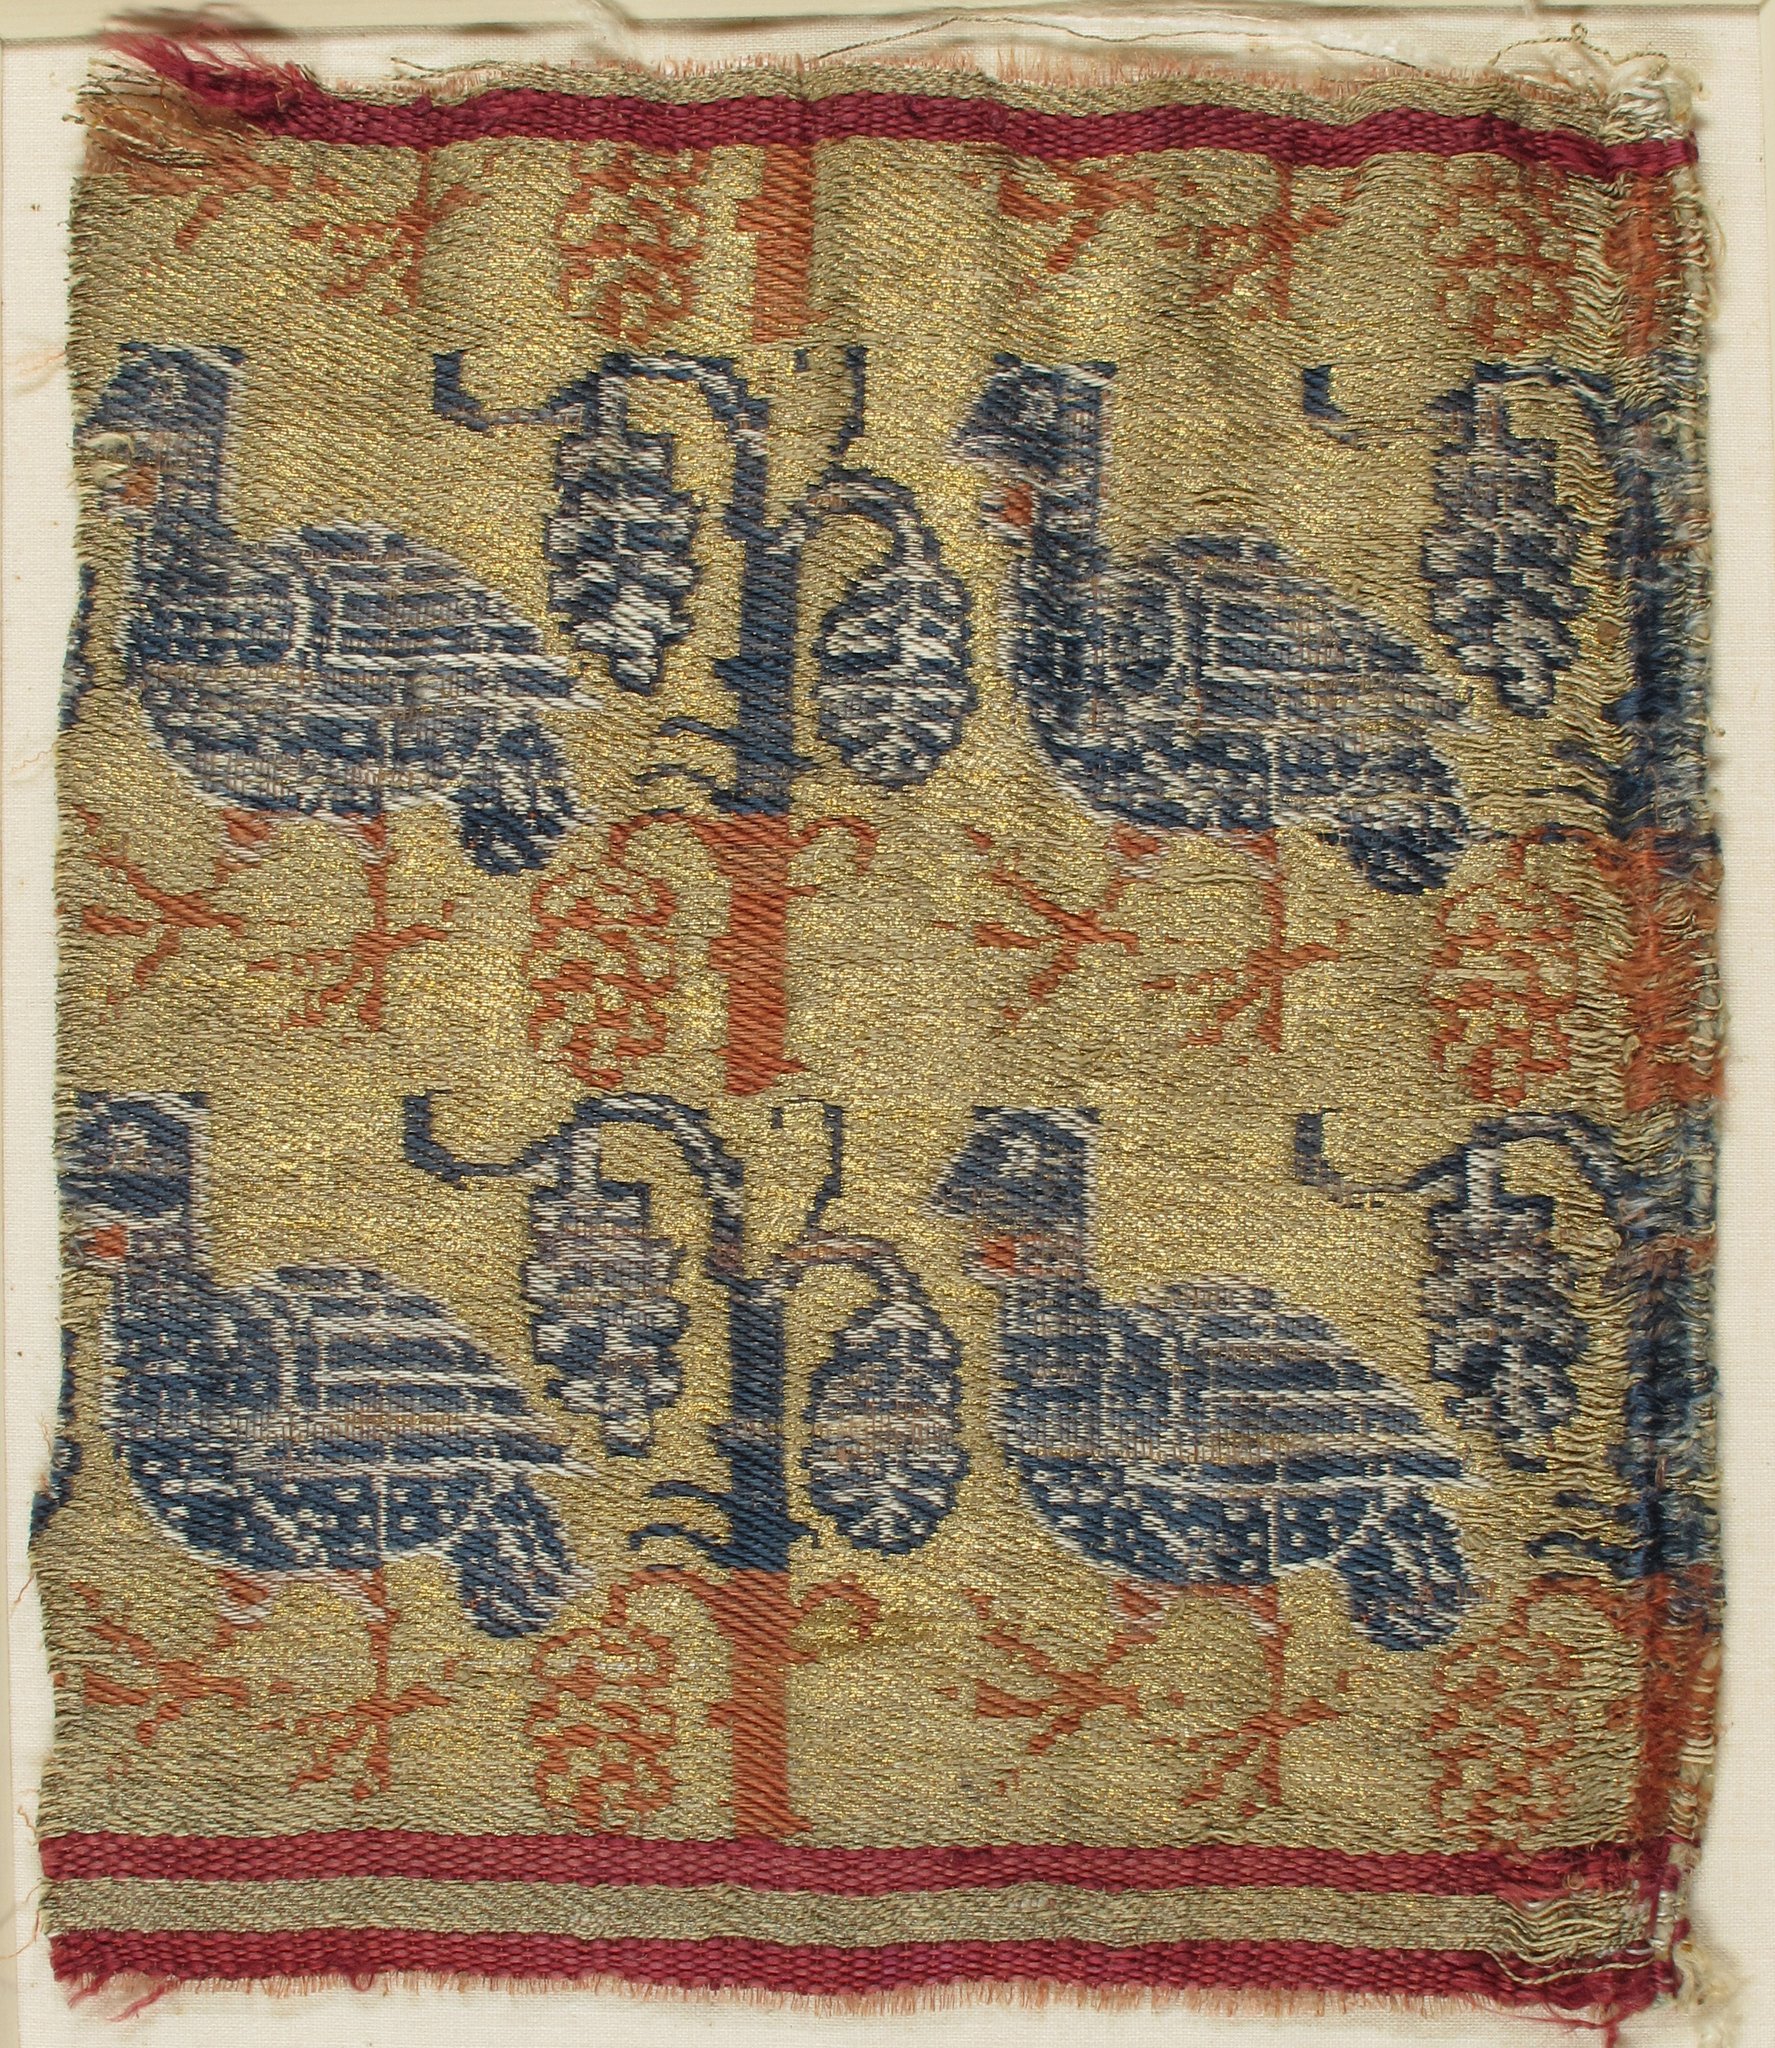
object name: textile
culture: european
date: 1201-1300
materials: silk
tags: birds